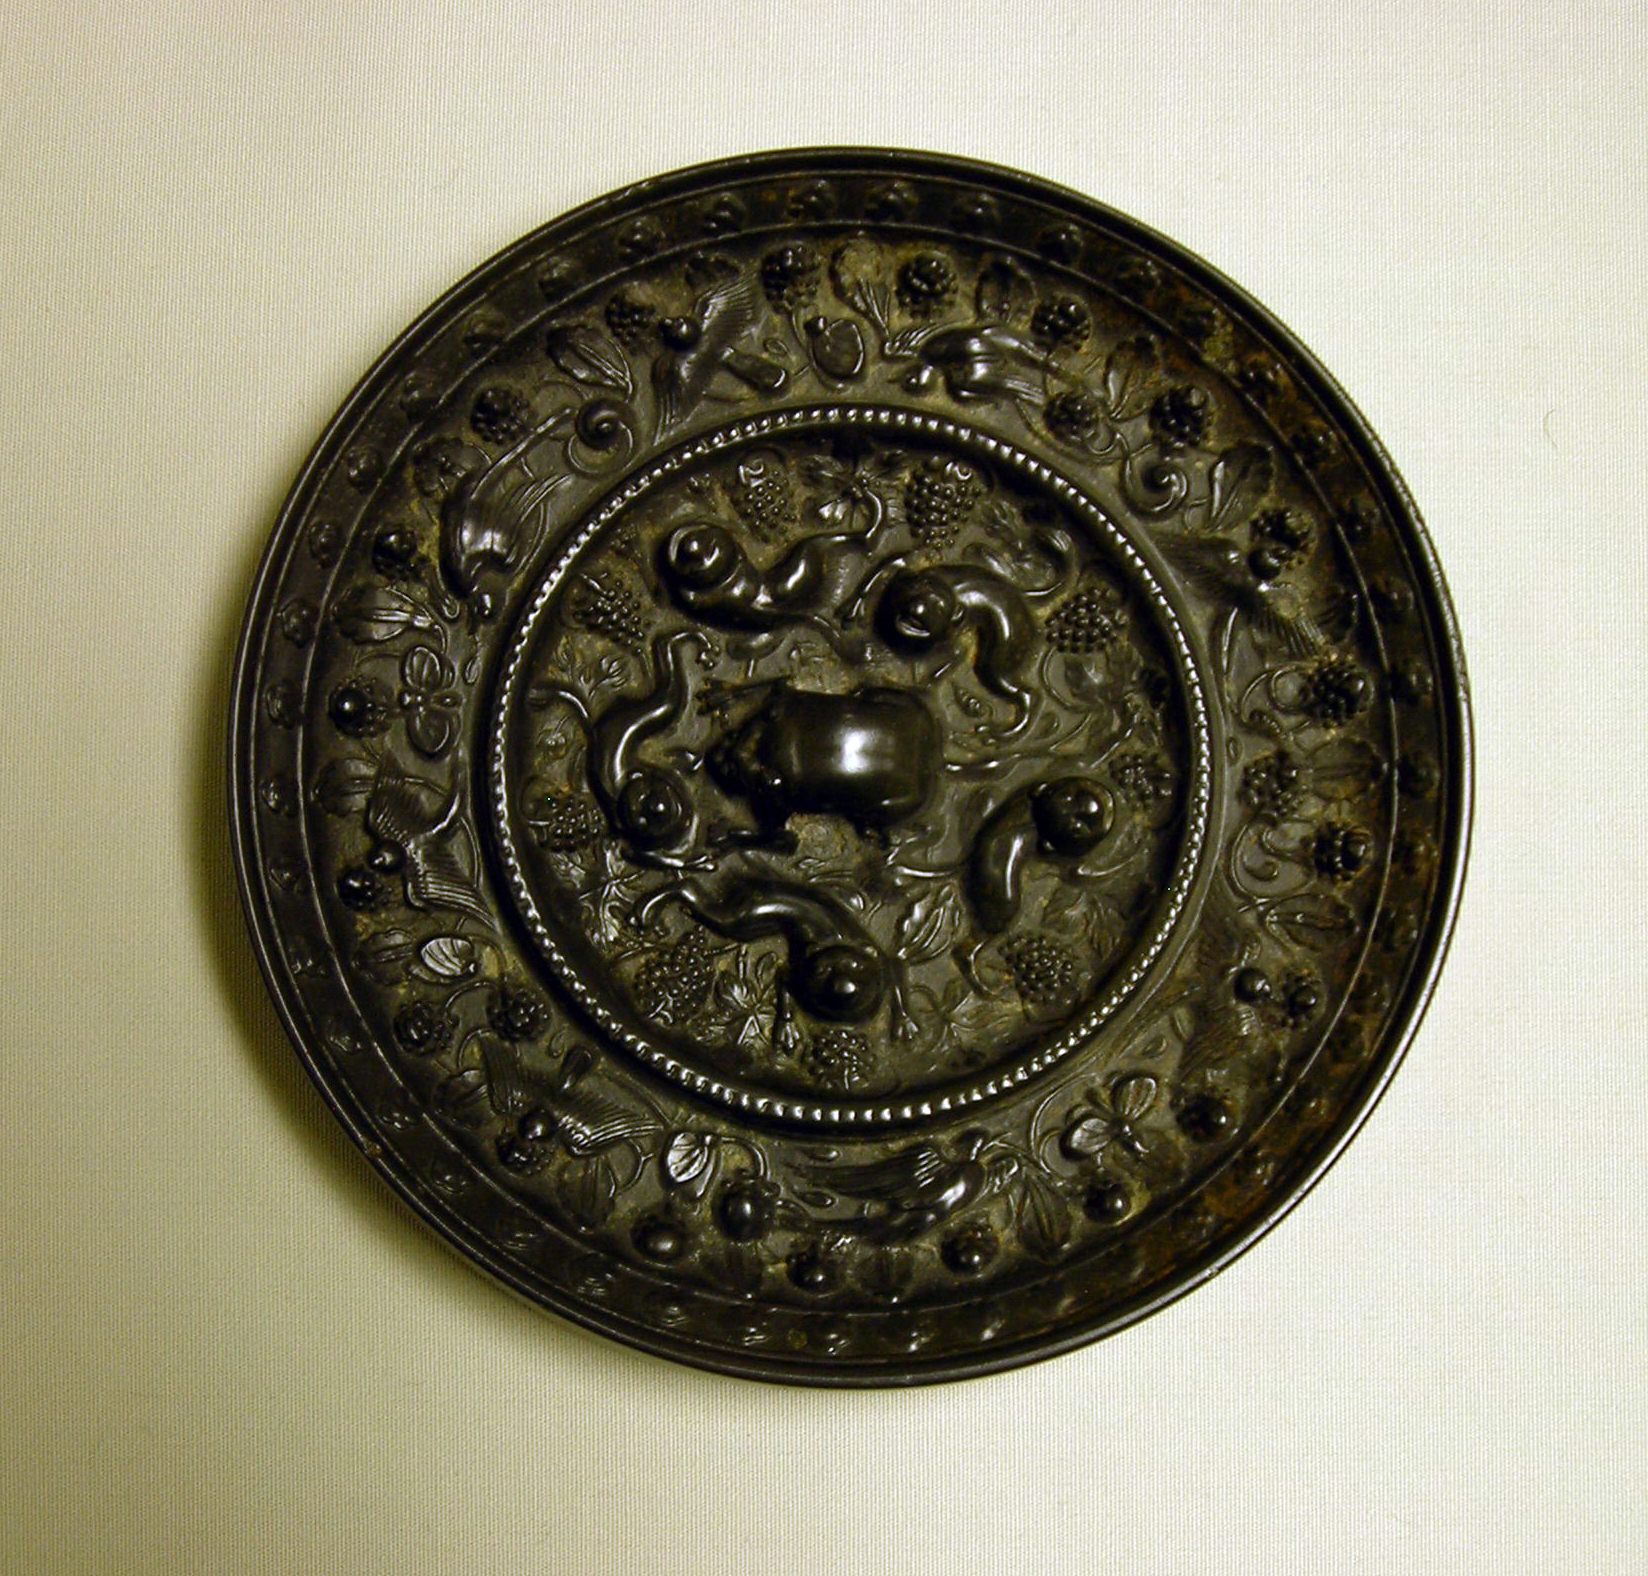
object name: mirror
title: Mirror with fantastic animals amid grape vines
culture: chinese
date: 601-800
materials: bronze, patina